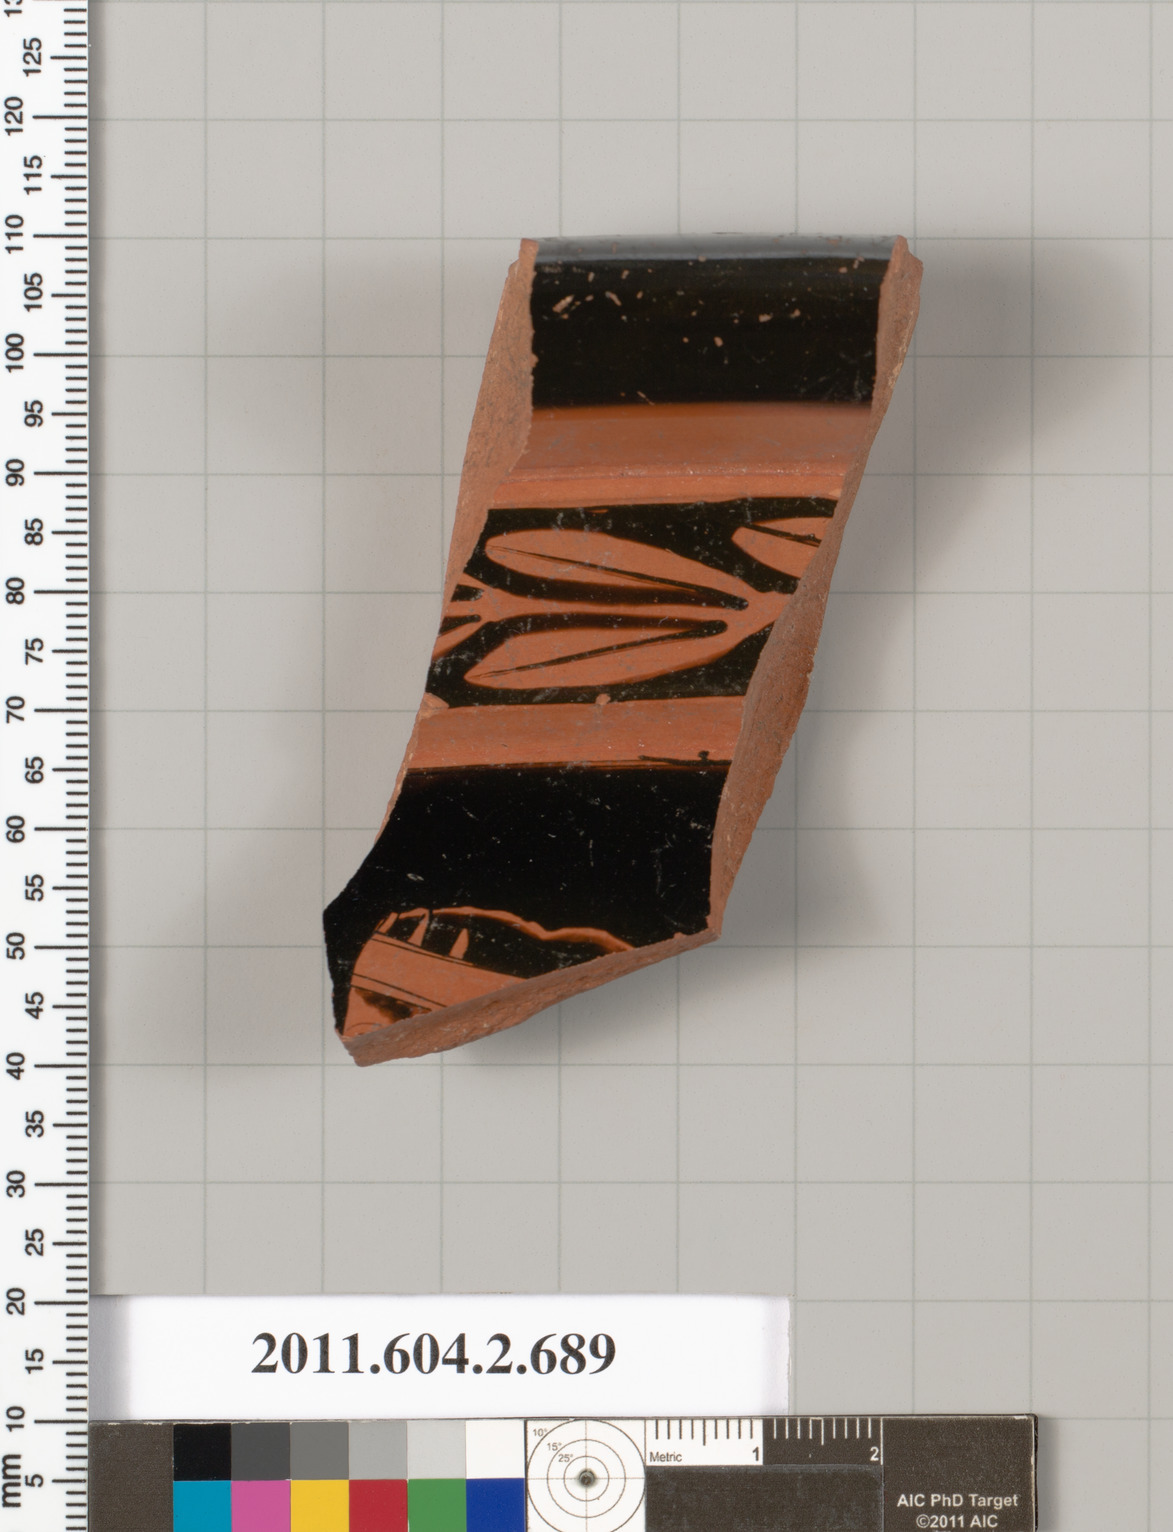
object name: calyx krater fragment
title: Terracotta fragment of a calyx-krater (bowl for mixing wine and water)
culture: greek, attic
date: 467-435 BCE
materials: terracotta